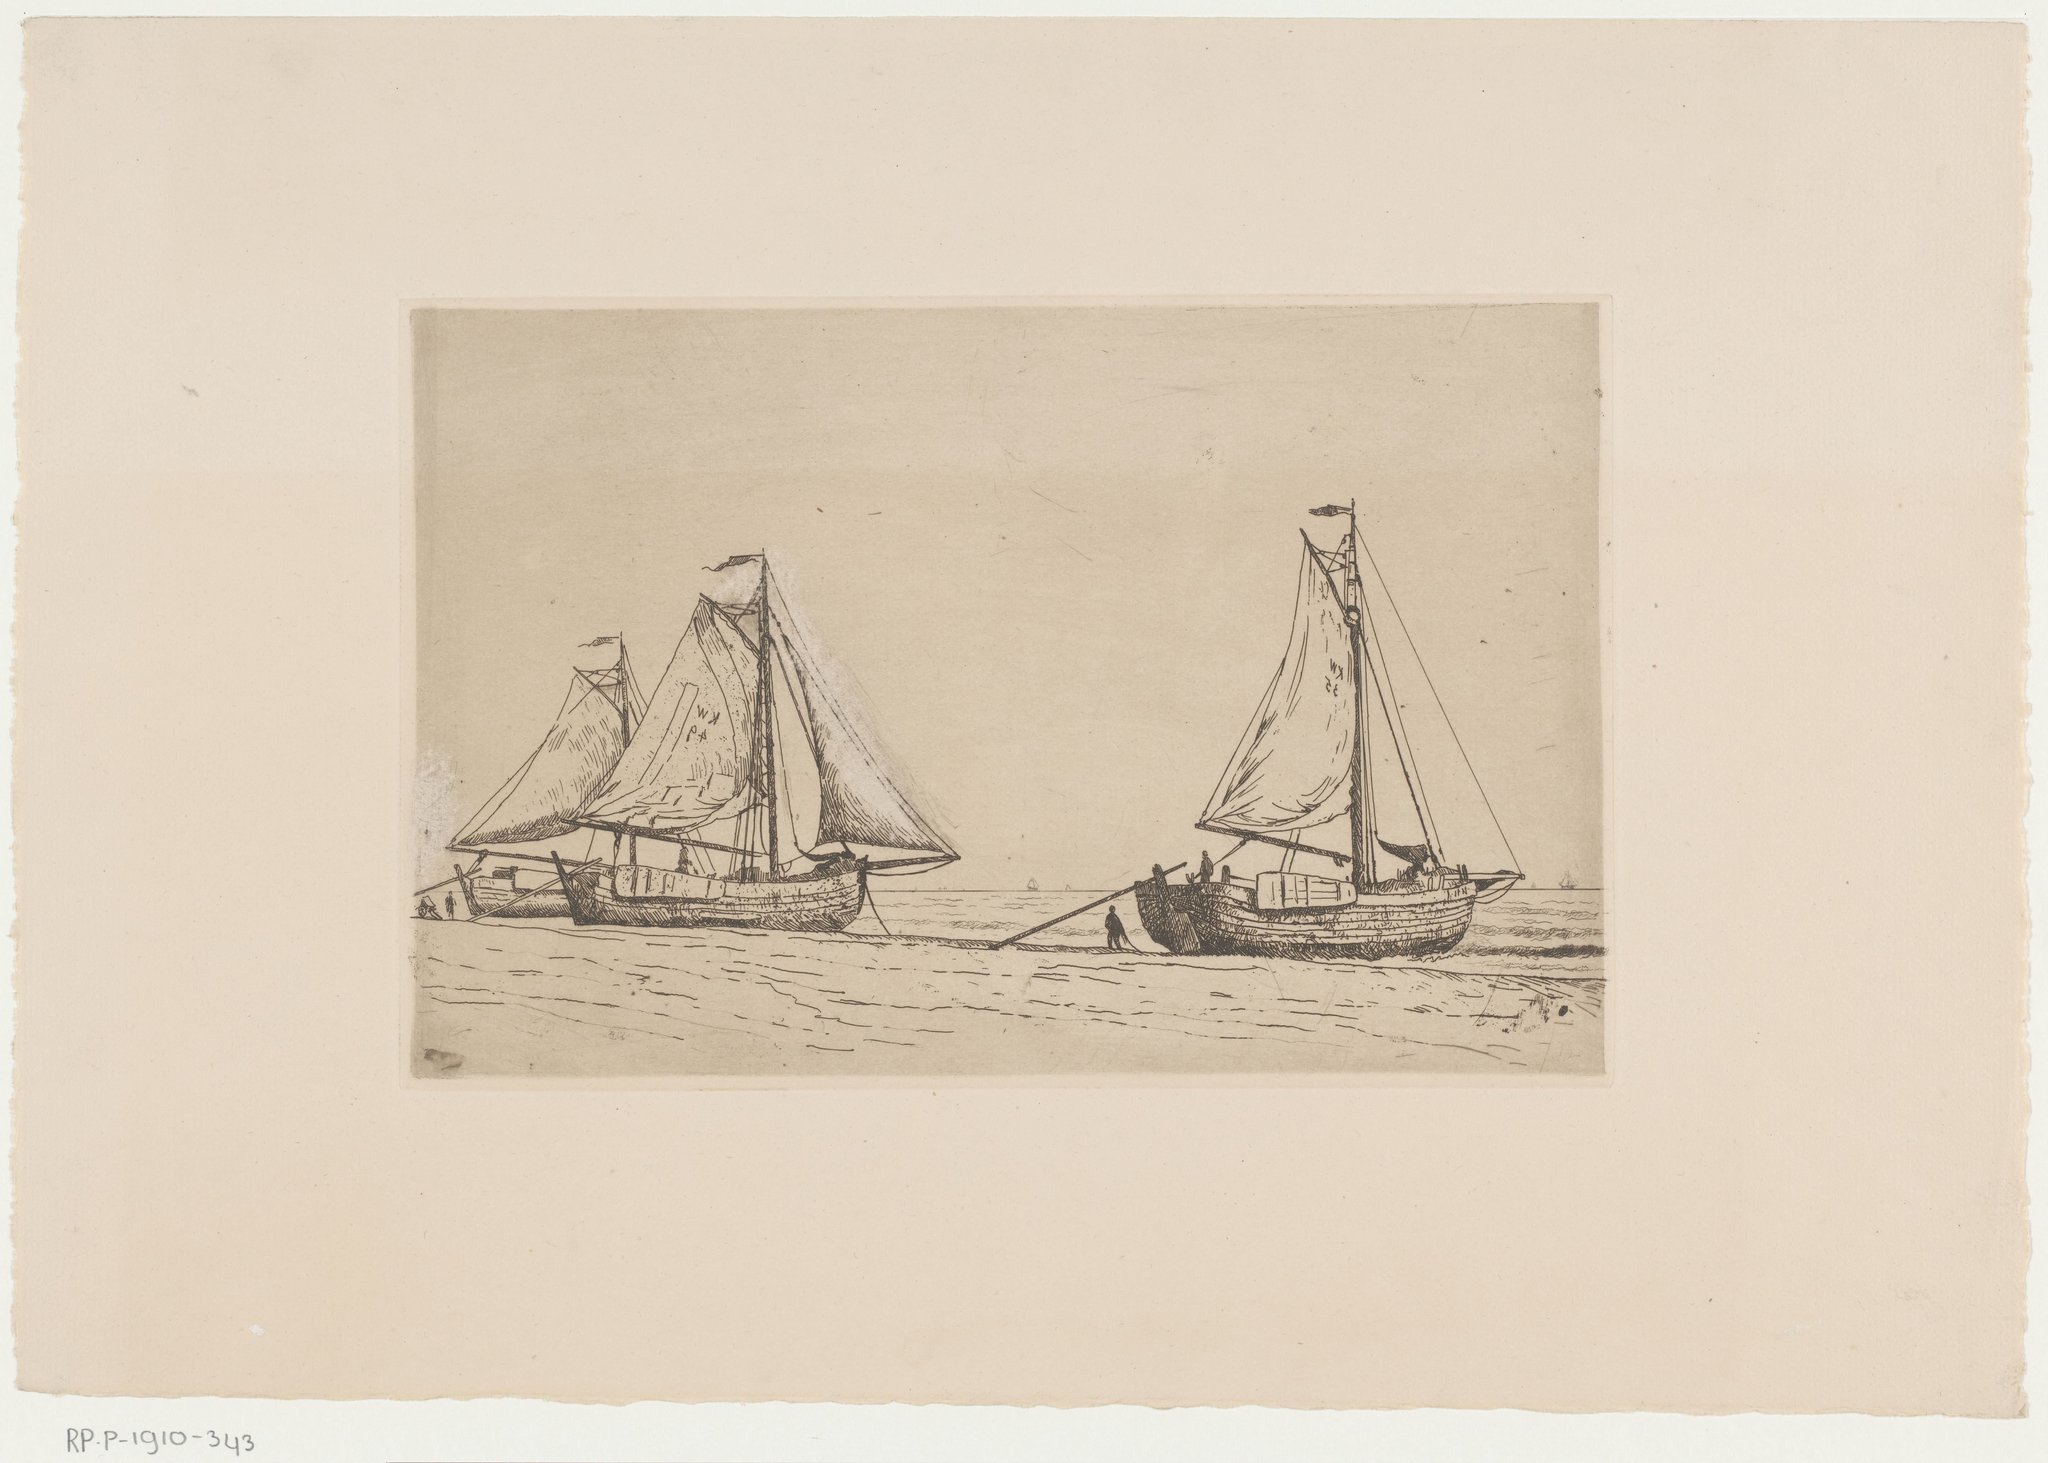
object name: print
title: Drie vissersboten op het strand van Katwijk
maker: alphonse stengelin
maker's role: painter, print maker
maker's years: 1852-1938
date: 1862-1910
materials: paper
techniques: etching, intaglio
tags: commercial fishery, sailing-ship, sailing-boat, beach, sea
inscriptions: collector's mark: Lugt 2228